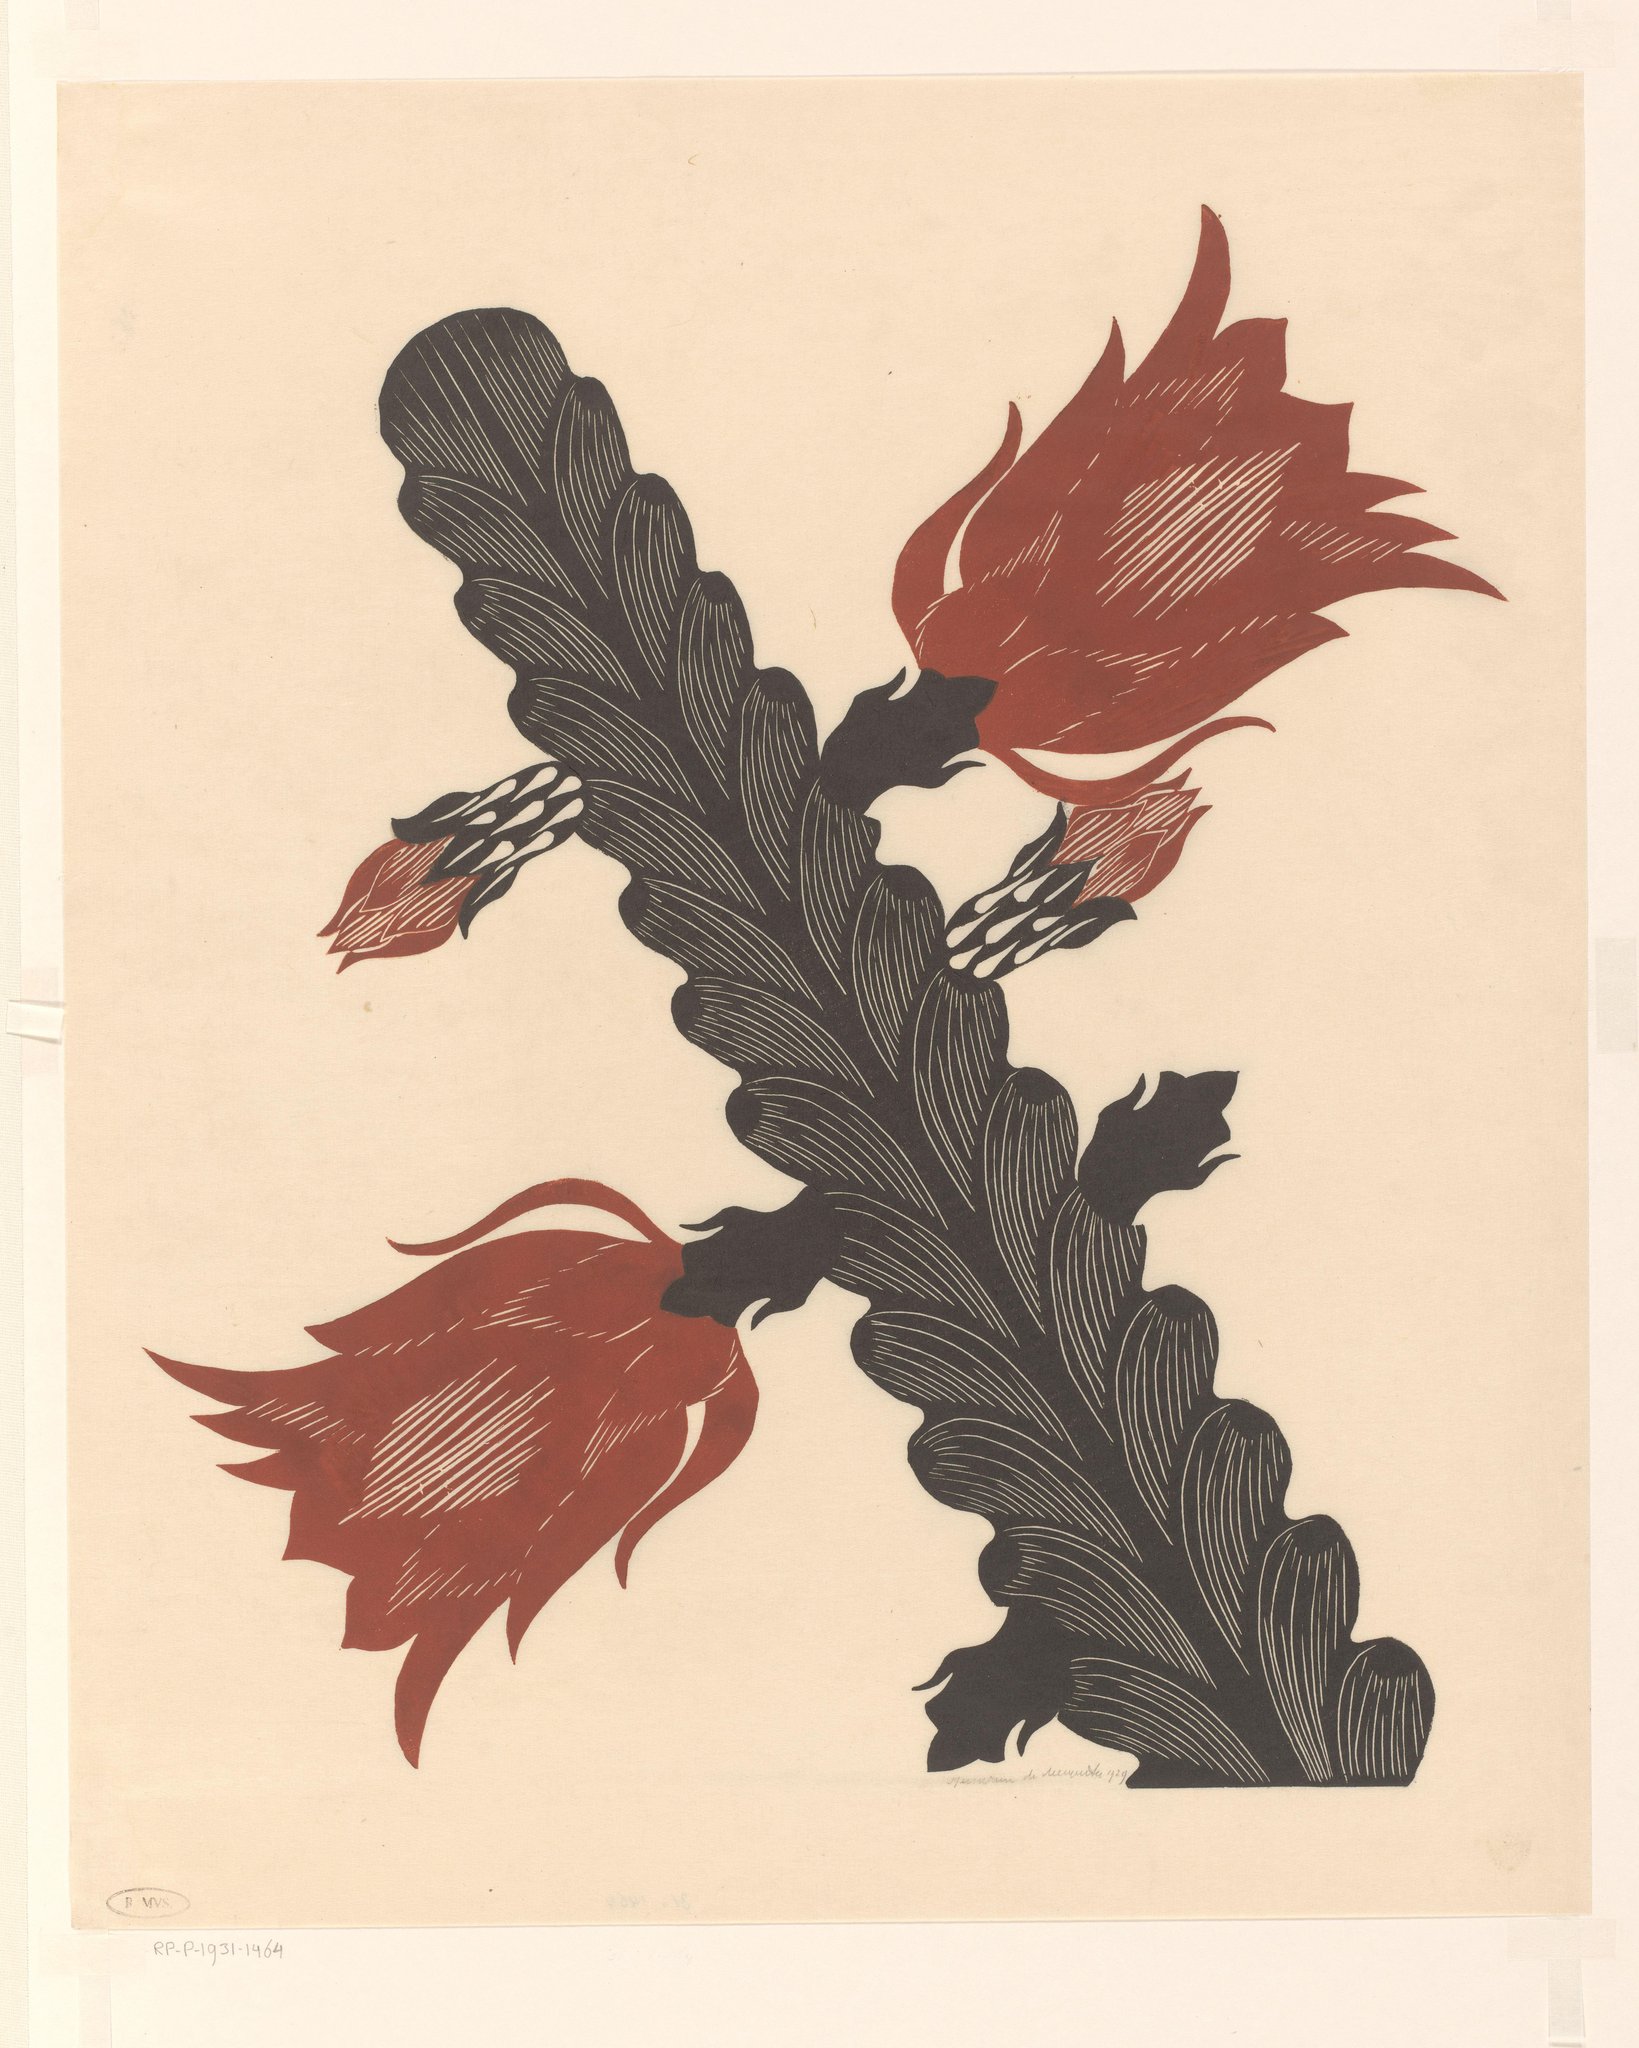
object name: print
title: Bloeiende cactus (epiphyllum)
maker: samuel jessurun de mesquita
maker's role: draughtsman, print maker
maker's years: 1868-1944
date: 1929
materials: paper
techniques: woodcut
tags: plants and herbs: cactus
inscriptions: collector's mark: Lugt 2228